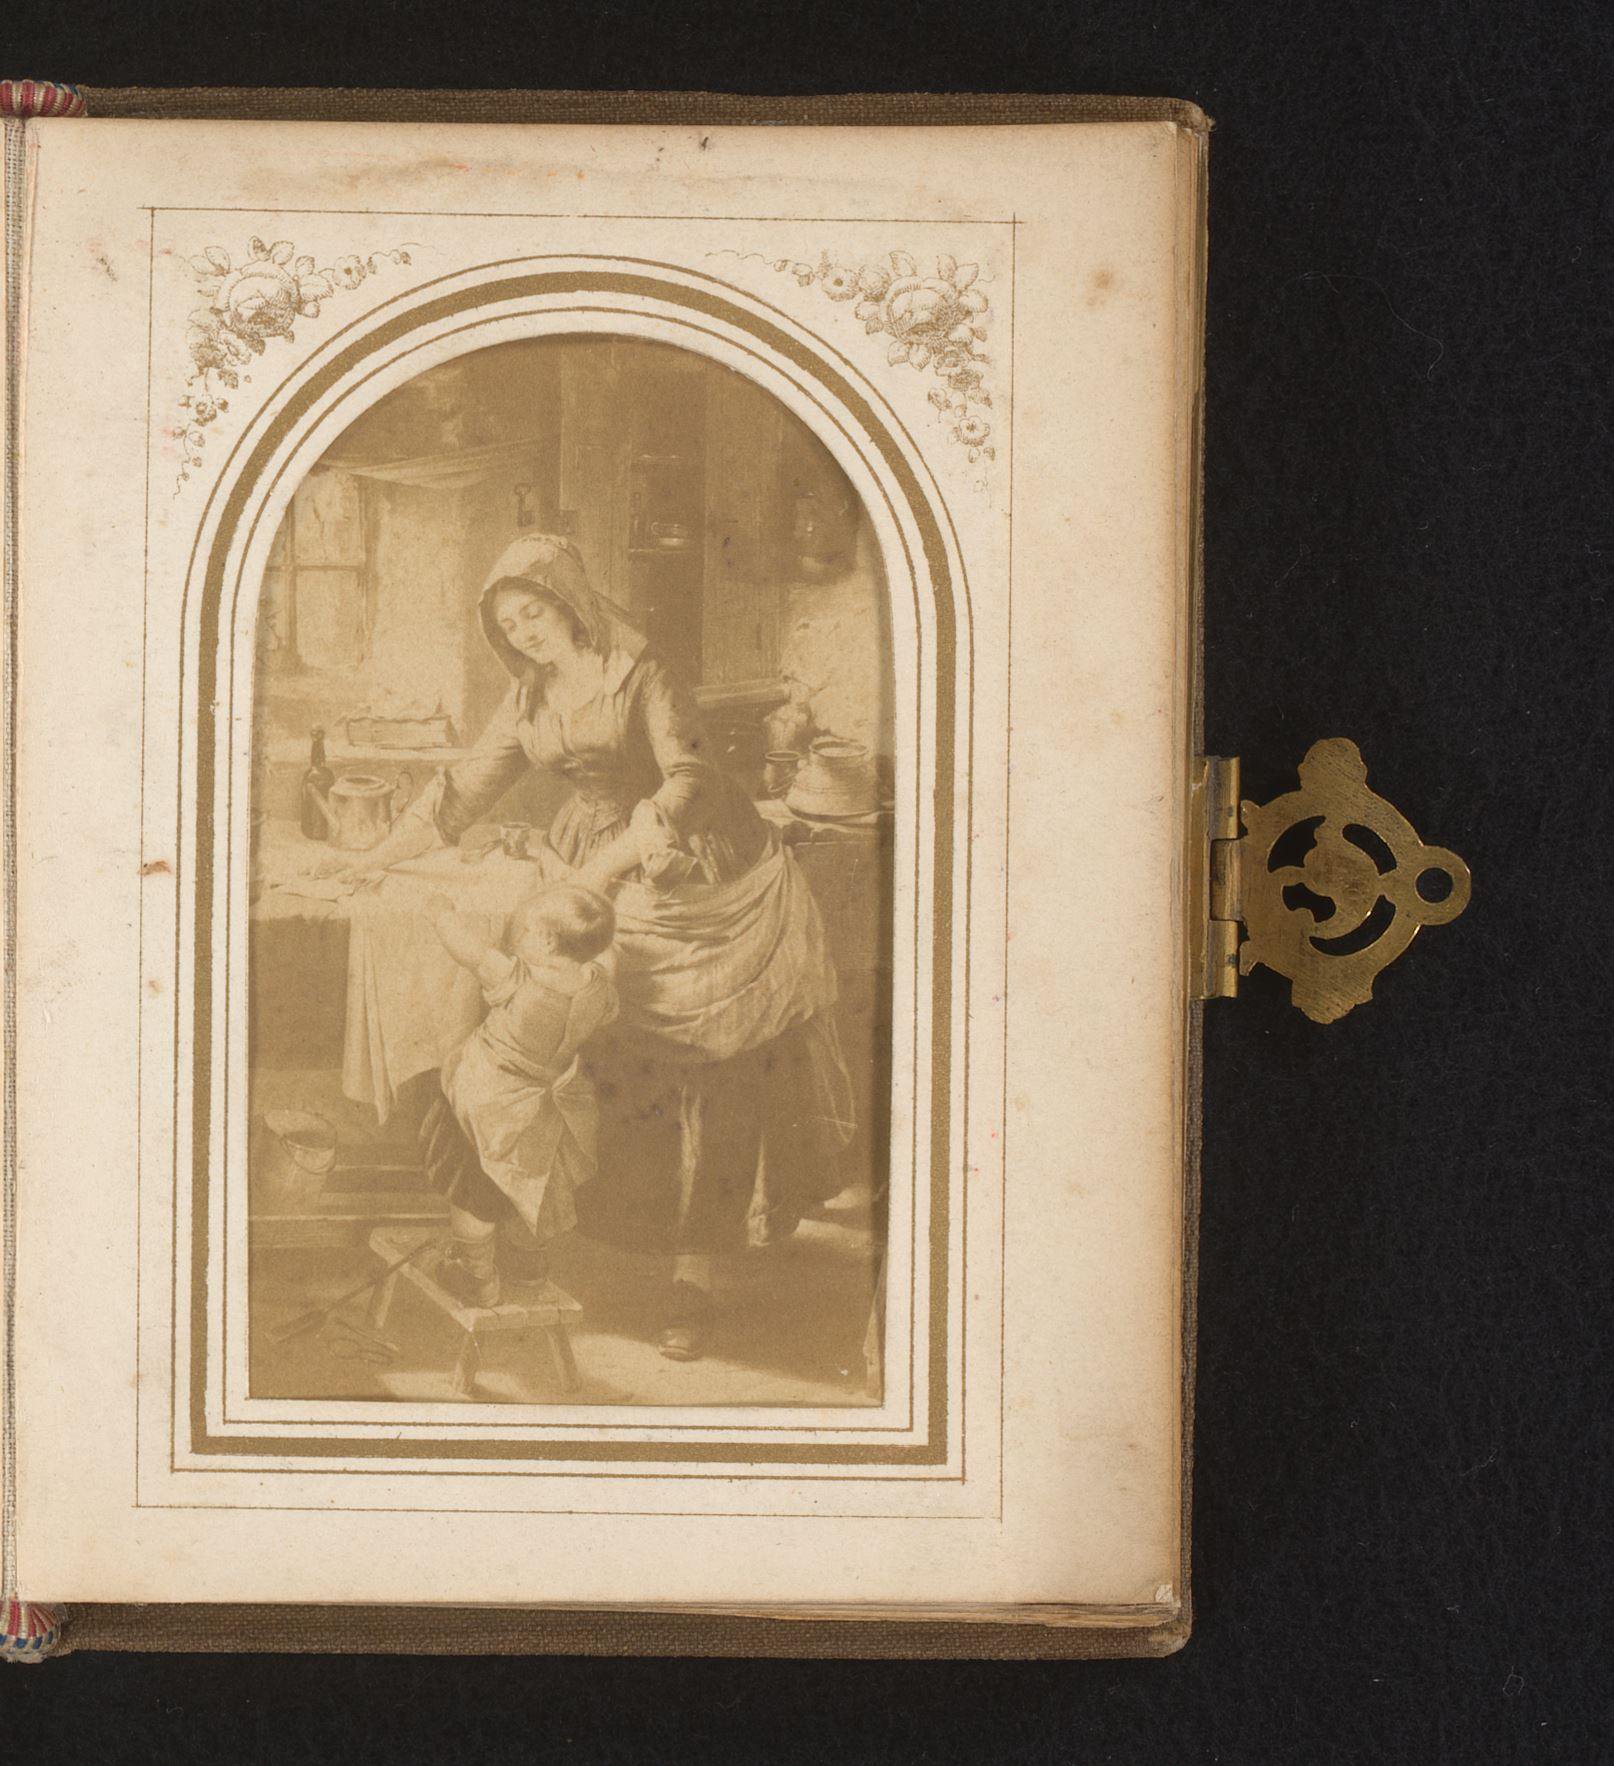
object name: album leaf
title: Fotoreproductie van een schilderij; een genretafereel van vrouw met een kind in de keuken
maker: Anonymous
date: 1870-1900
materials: cardboard, photographic support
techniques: albumen print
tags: kitchen-interior, mother and child(ren), woman and child(ren) (family group), painting, drawing and the graphic arts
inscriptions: annotation: ‘[...]’, annotation: ‘Papa komt!/ 129’